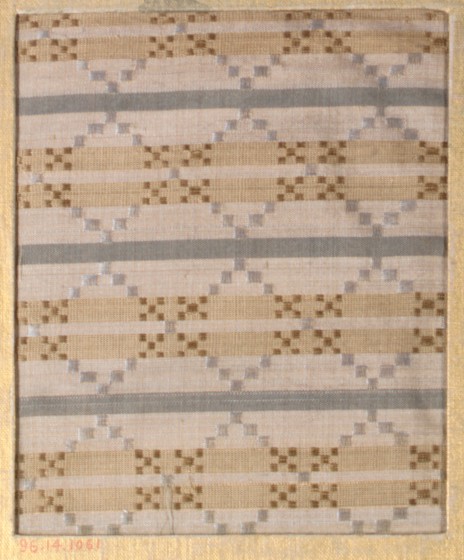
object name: piece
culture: japanese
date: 1701-1900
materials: silk